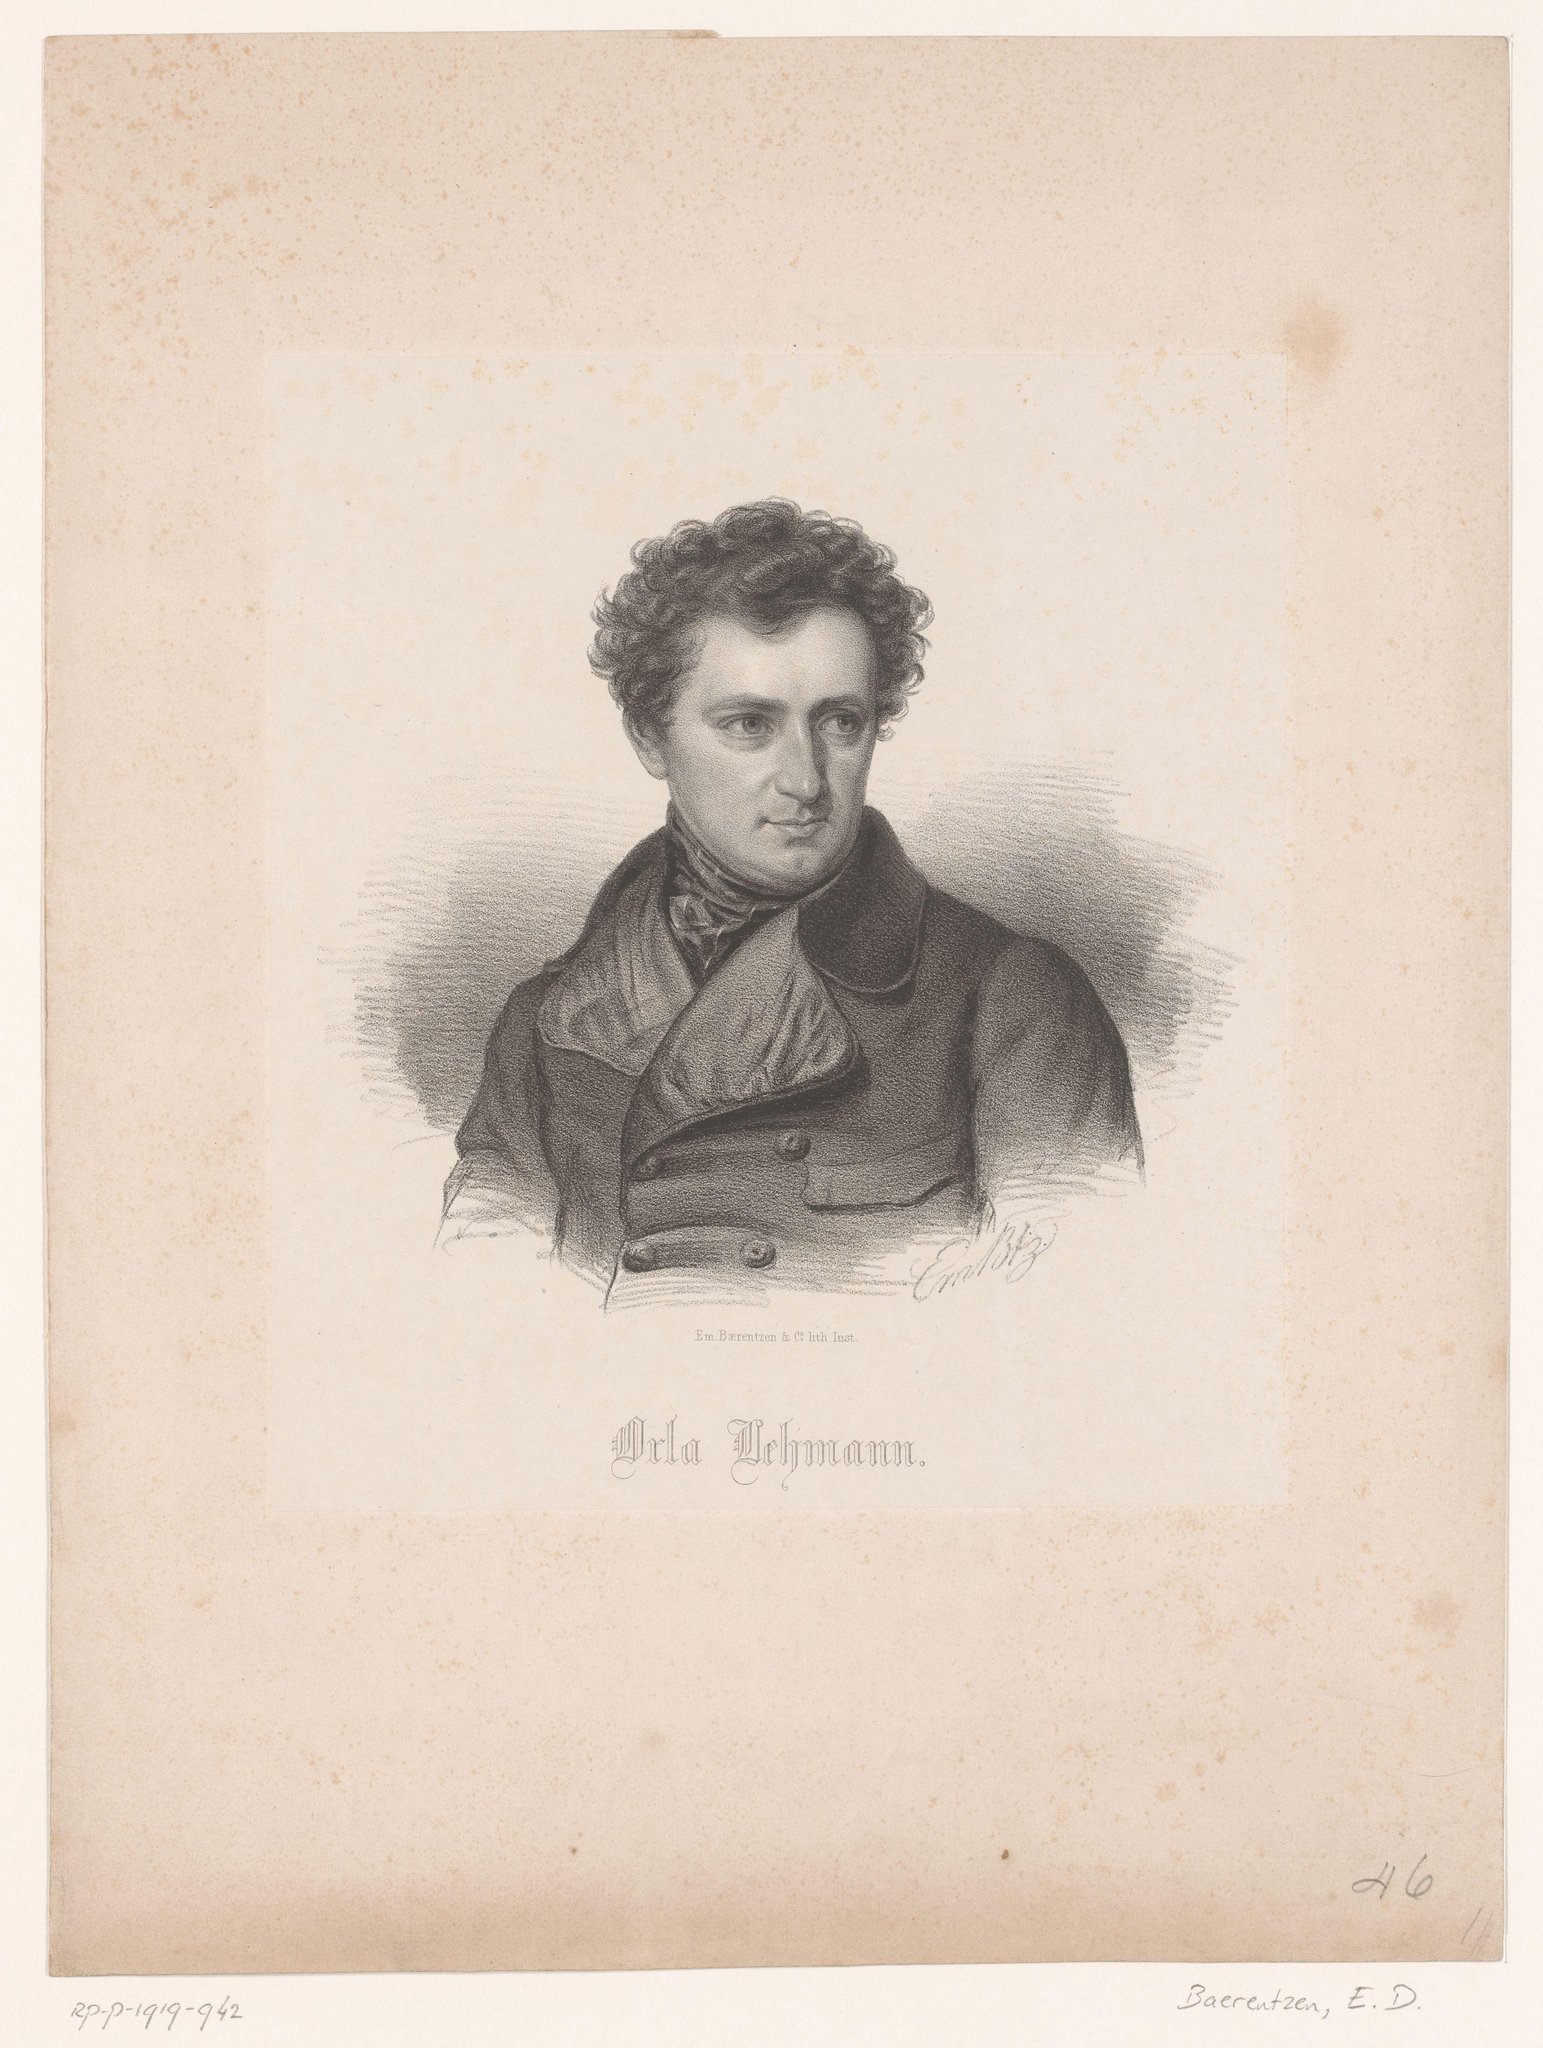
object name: print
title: Portret van Orla Lehmann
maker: emilius ditlev baerentzen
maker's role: print maker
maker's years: 1799-1868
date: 1837-1868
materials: paper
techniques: lithograph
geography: copenhagen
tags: politician, historical persons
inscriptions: inscription: ‘Orla Lethmann.’, inscription: ‘Em. Baerentzen & Co lith.Inst.’, collector's mark: Lugt 2228, signature: ‘EmBtz.’